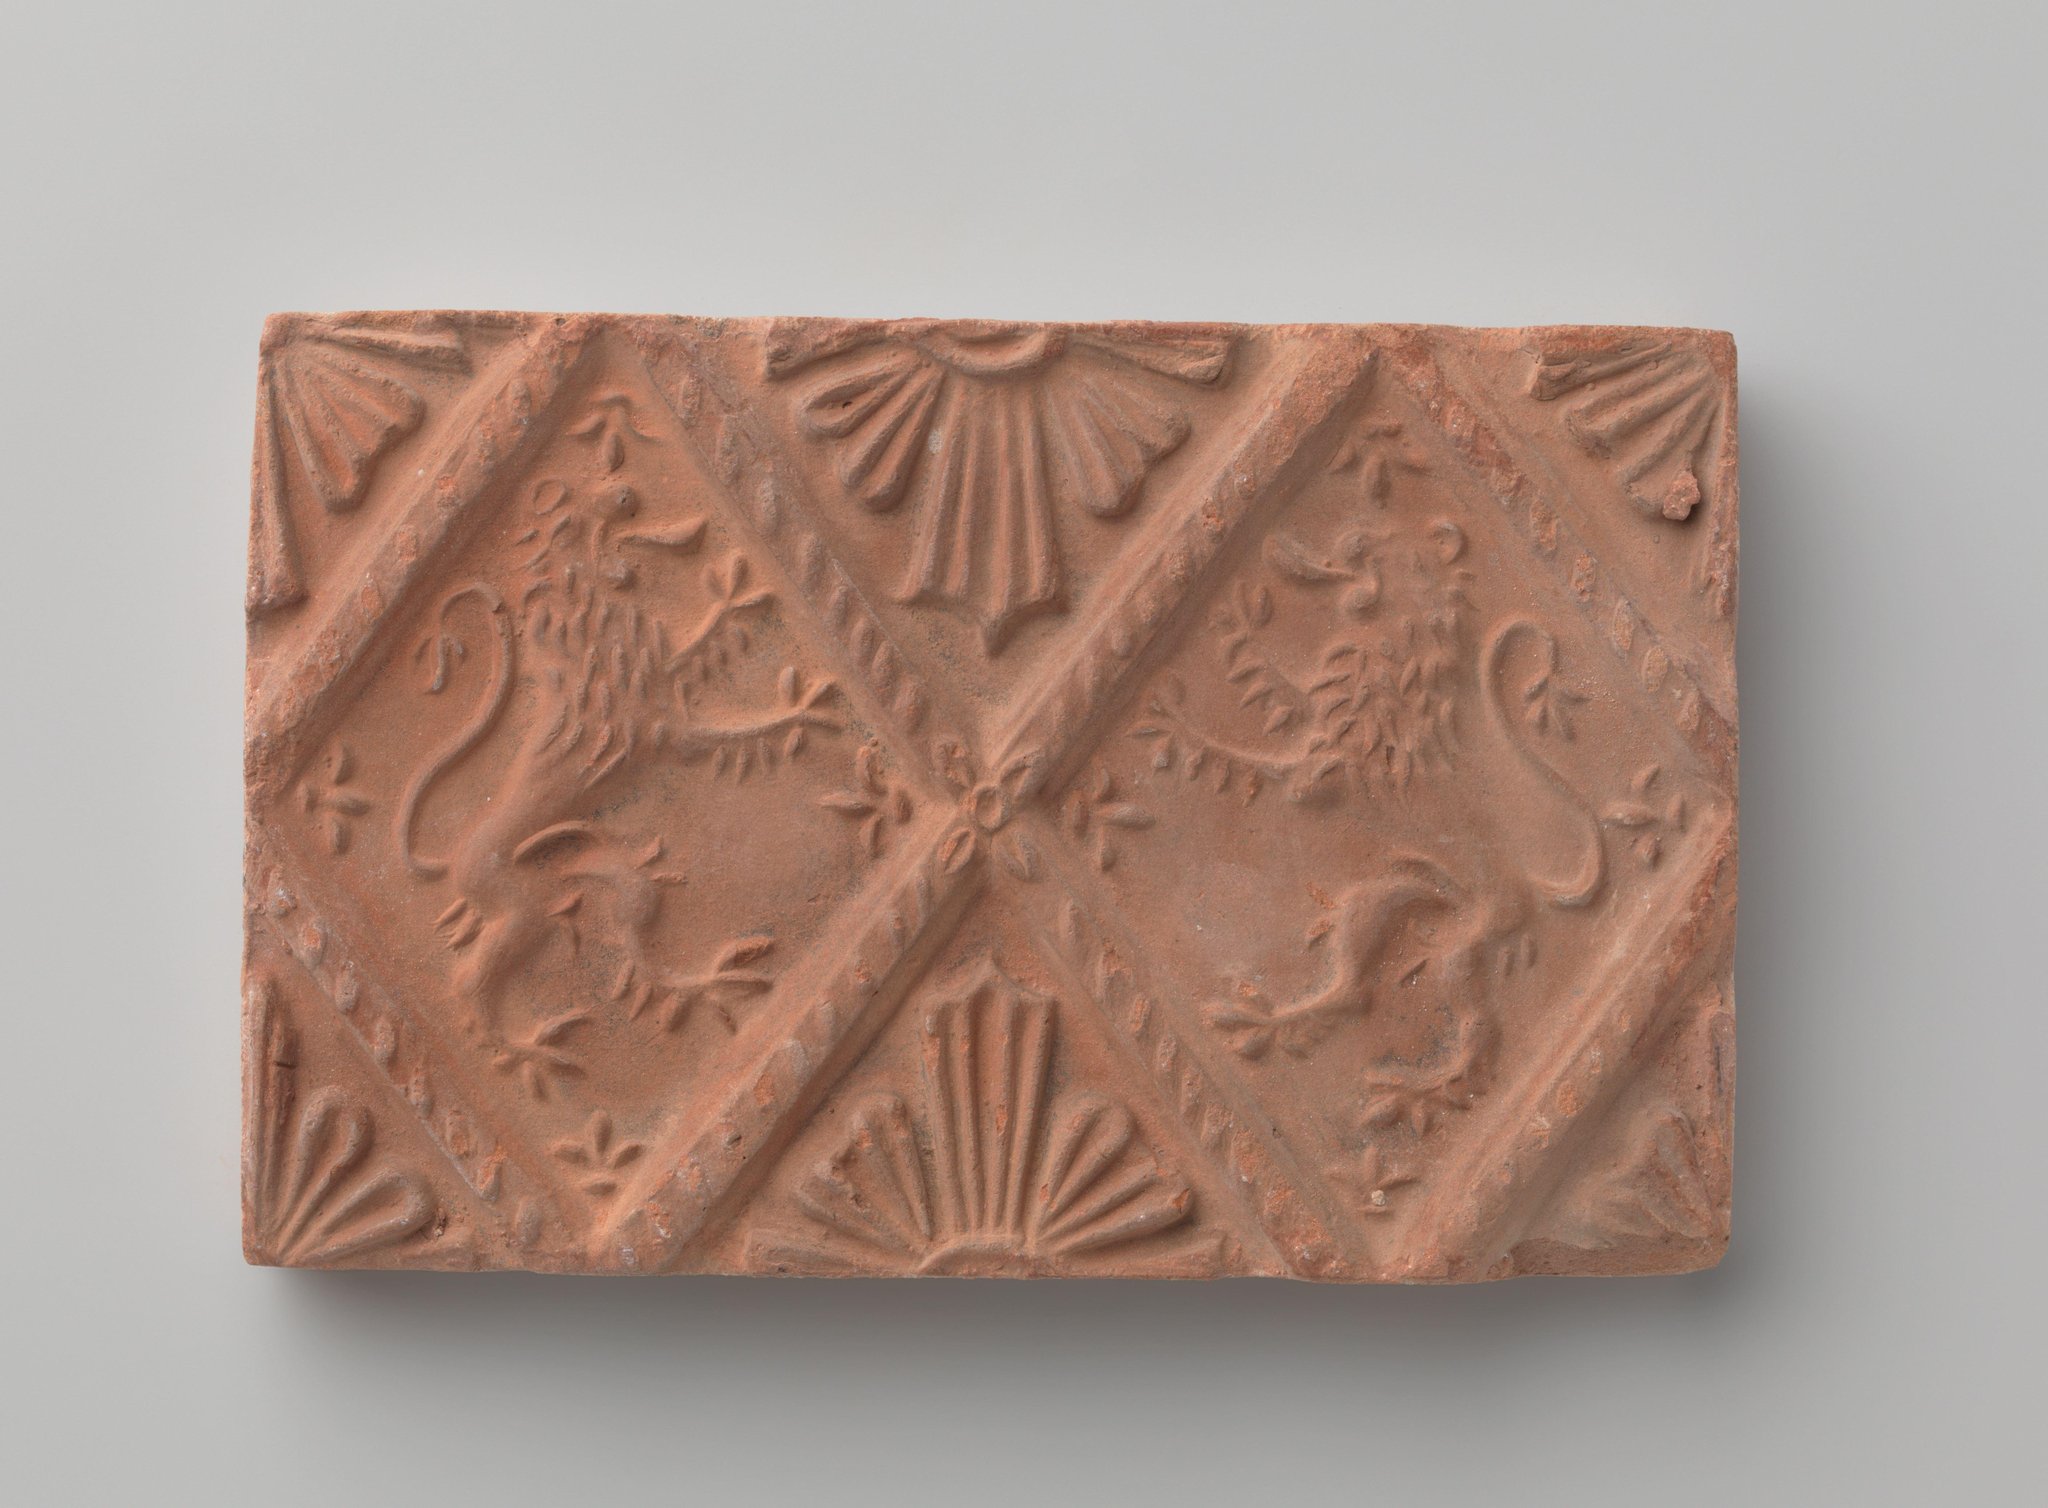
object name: hearthstone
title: Haardsteen met voorstelling van twee klimmende leeuwen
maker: Anonymous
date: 1875-1900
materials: earthenware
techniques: printing, firing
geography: netherlands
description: Haardsteen met voorstelling van twee klimmende leeuwen, geplaatst in geprofileerde ruit. De halve ruiten aan de boven- en onderkant zijn opgevuld met stermotief.